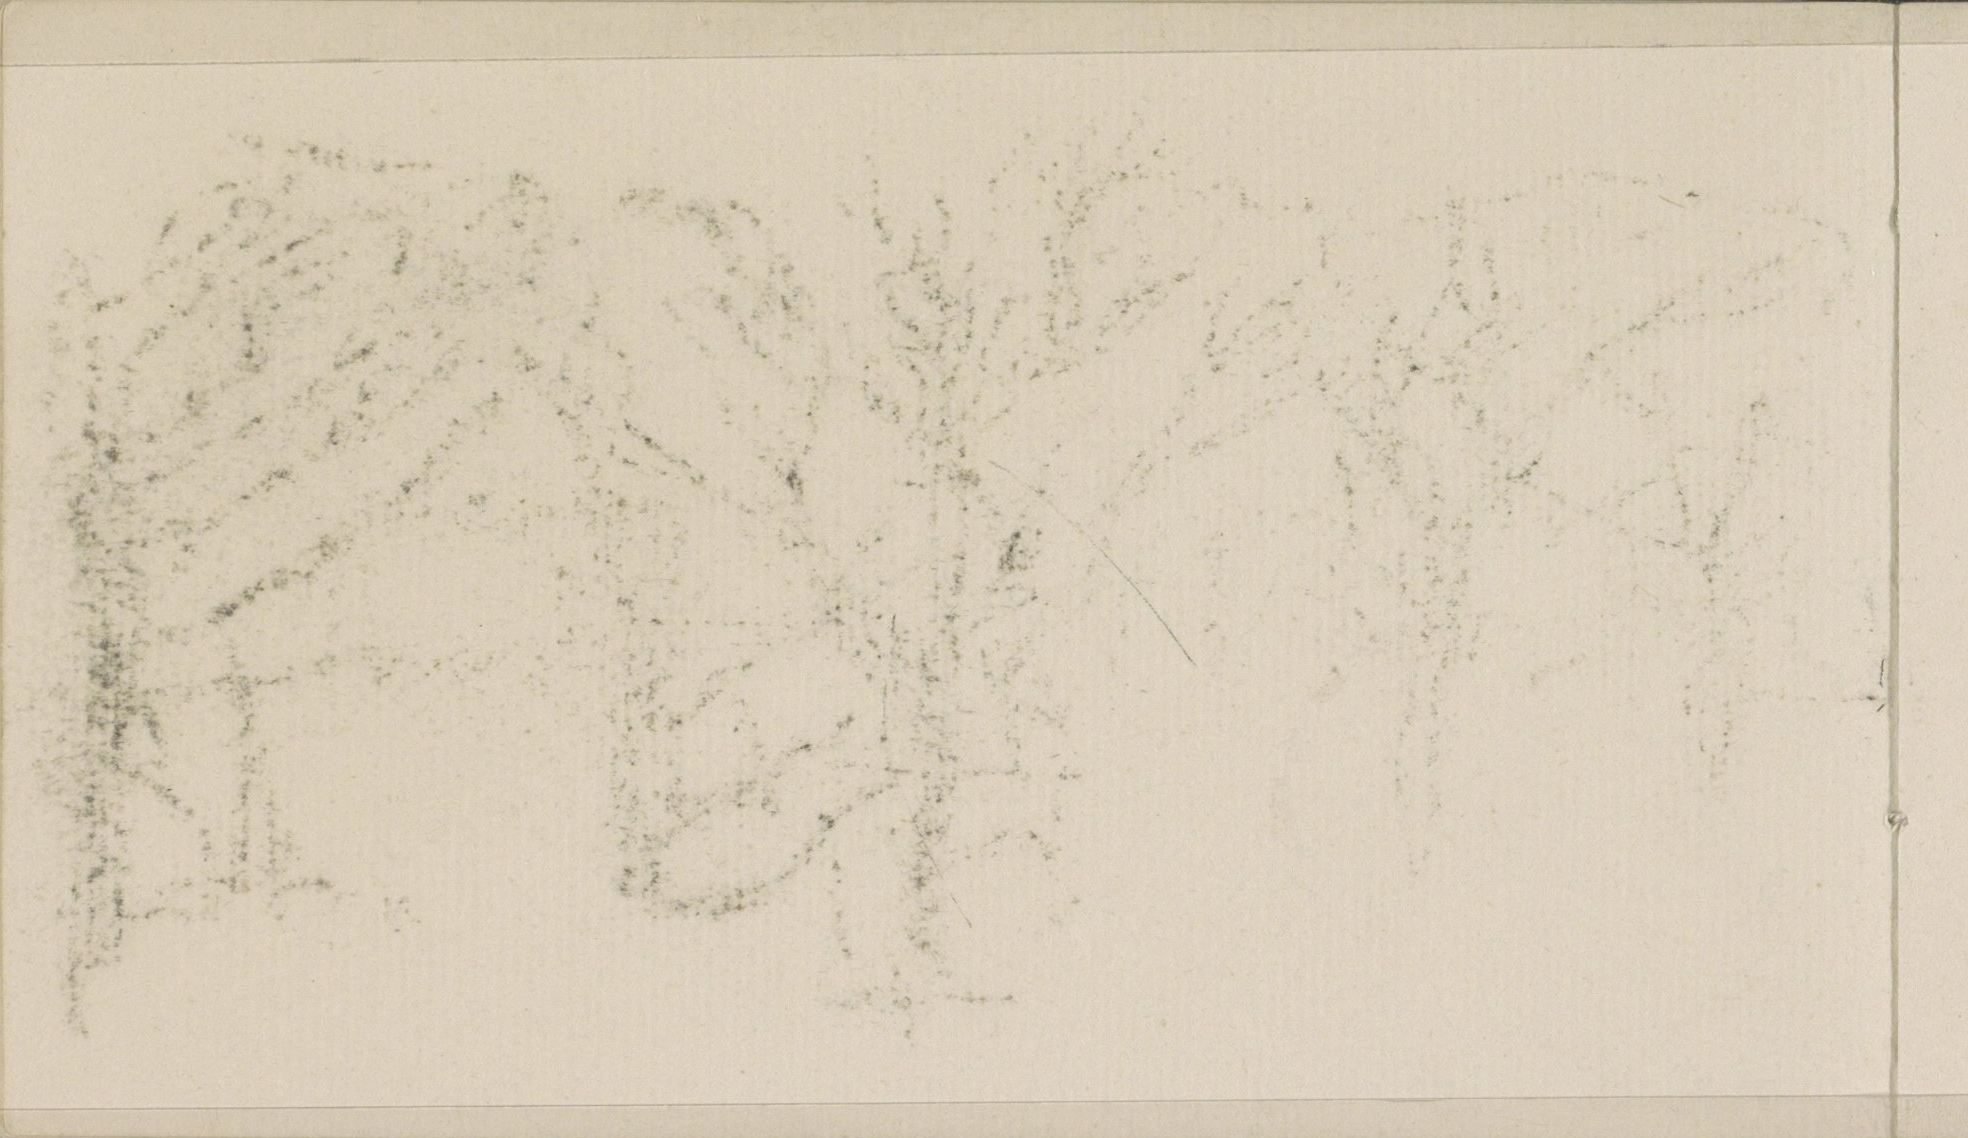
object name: sketchbook leaf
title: Studie, abklatsch van een krijttekening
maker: george hendrik breitner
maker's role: draughtsman, painter, print maker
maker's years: 1857-1923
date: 1909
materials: paper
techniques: printmaking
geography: amsterdam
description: De originele tekening is niet meer in het schetsboek aanwezig.